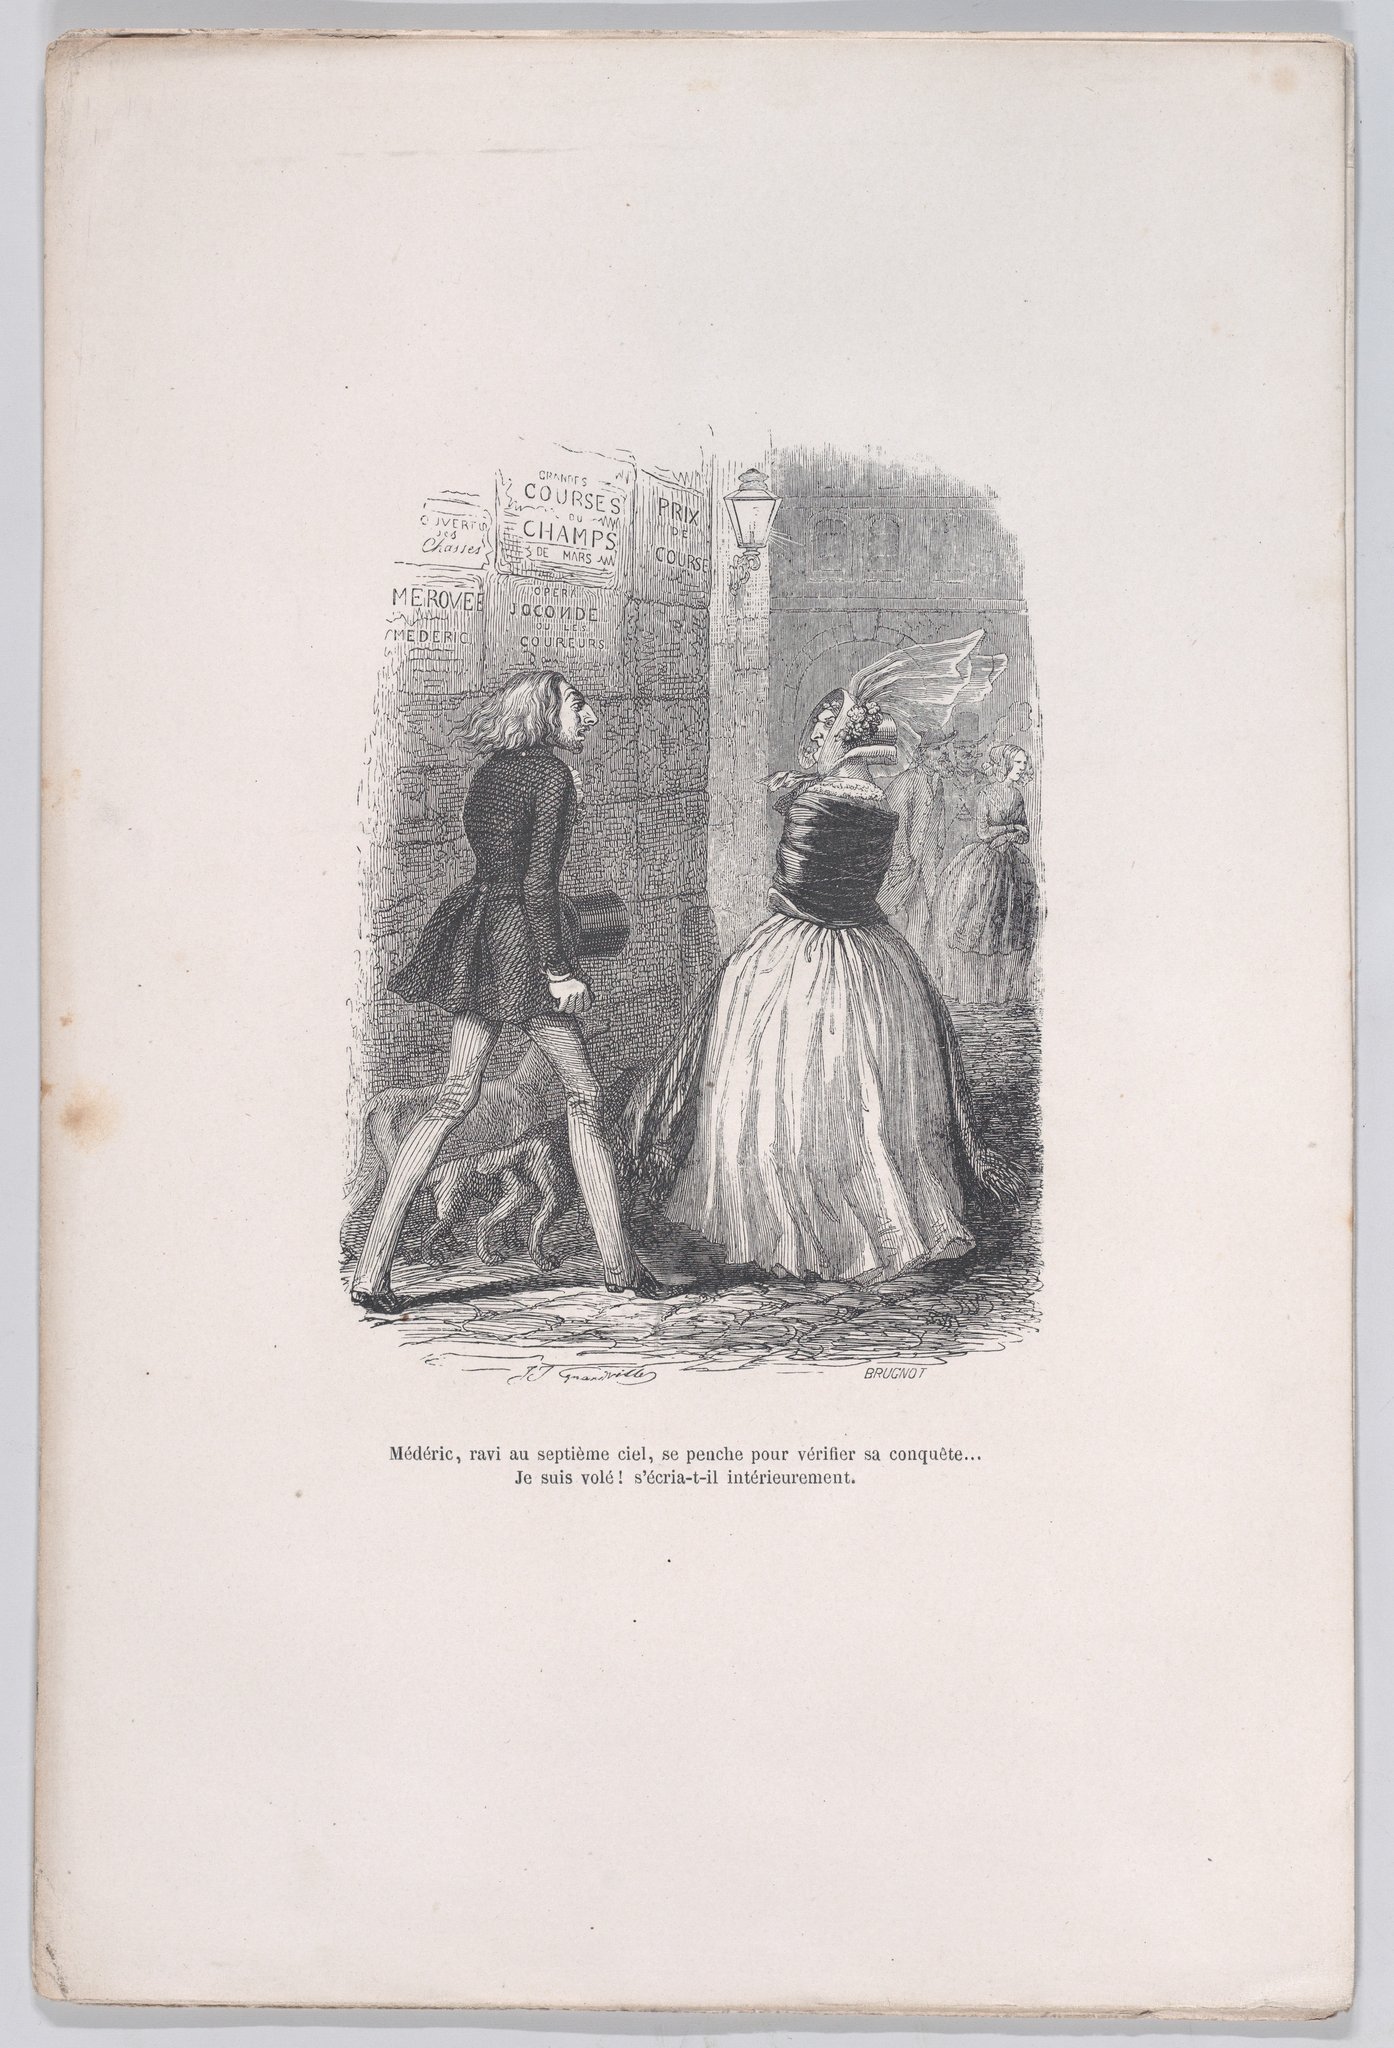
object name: print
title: Mèderic, delighted in the seventh heaven, leans over to check his conquest..., from "Little Miseries of Human Life"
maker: j. j. grandville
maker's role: illustrator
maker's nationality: french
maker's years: 1803-1847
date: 1843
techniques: engraving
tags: men,women